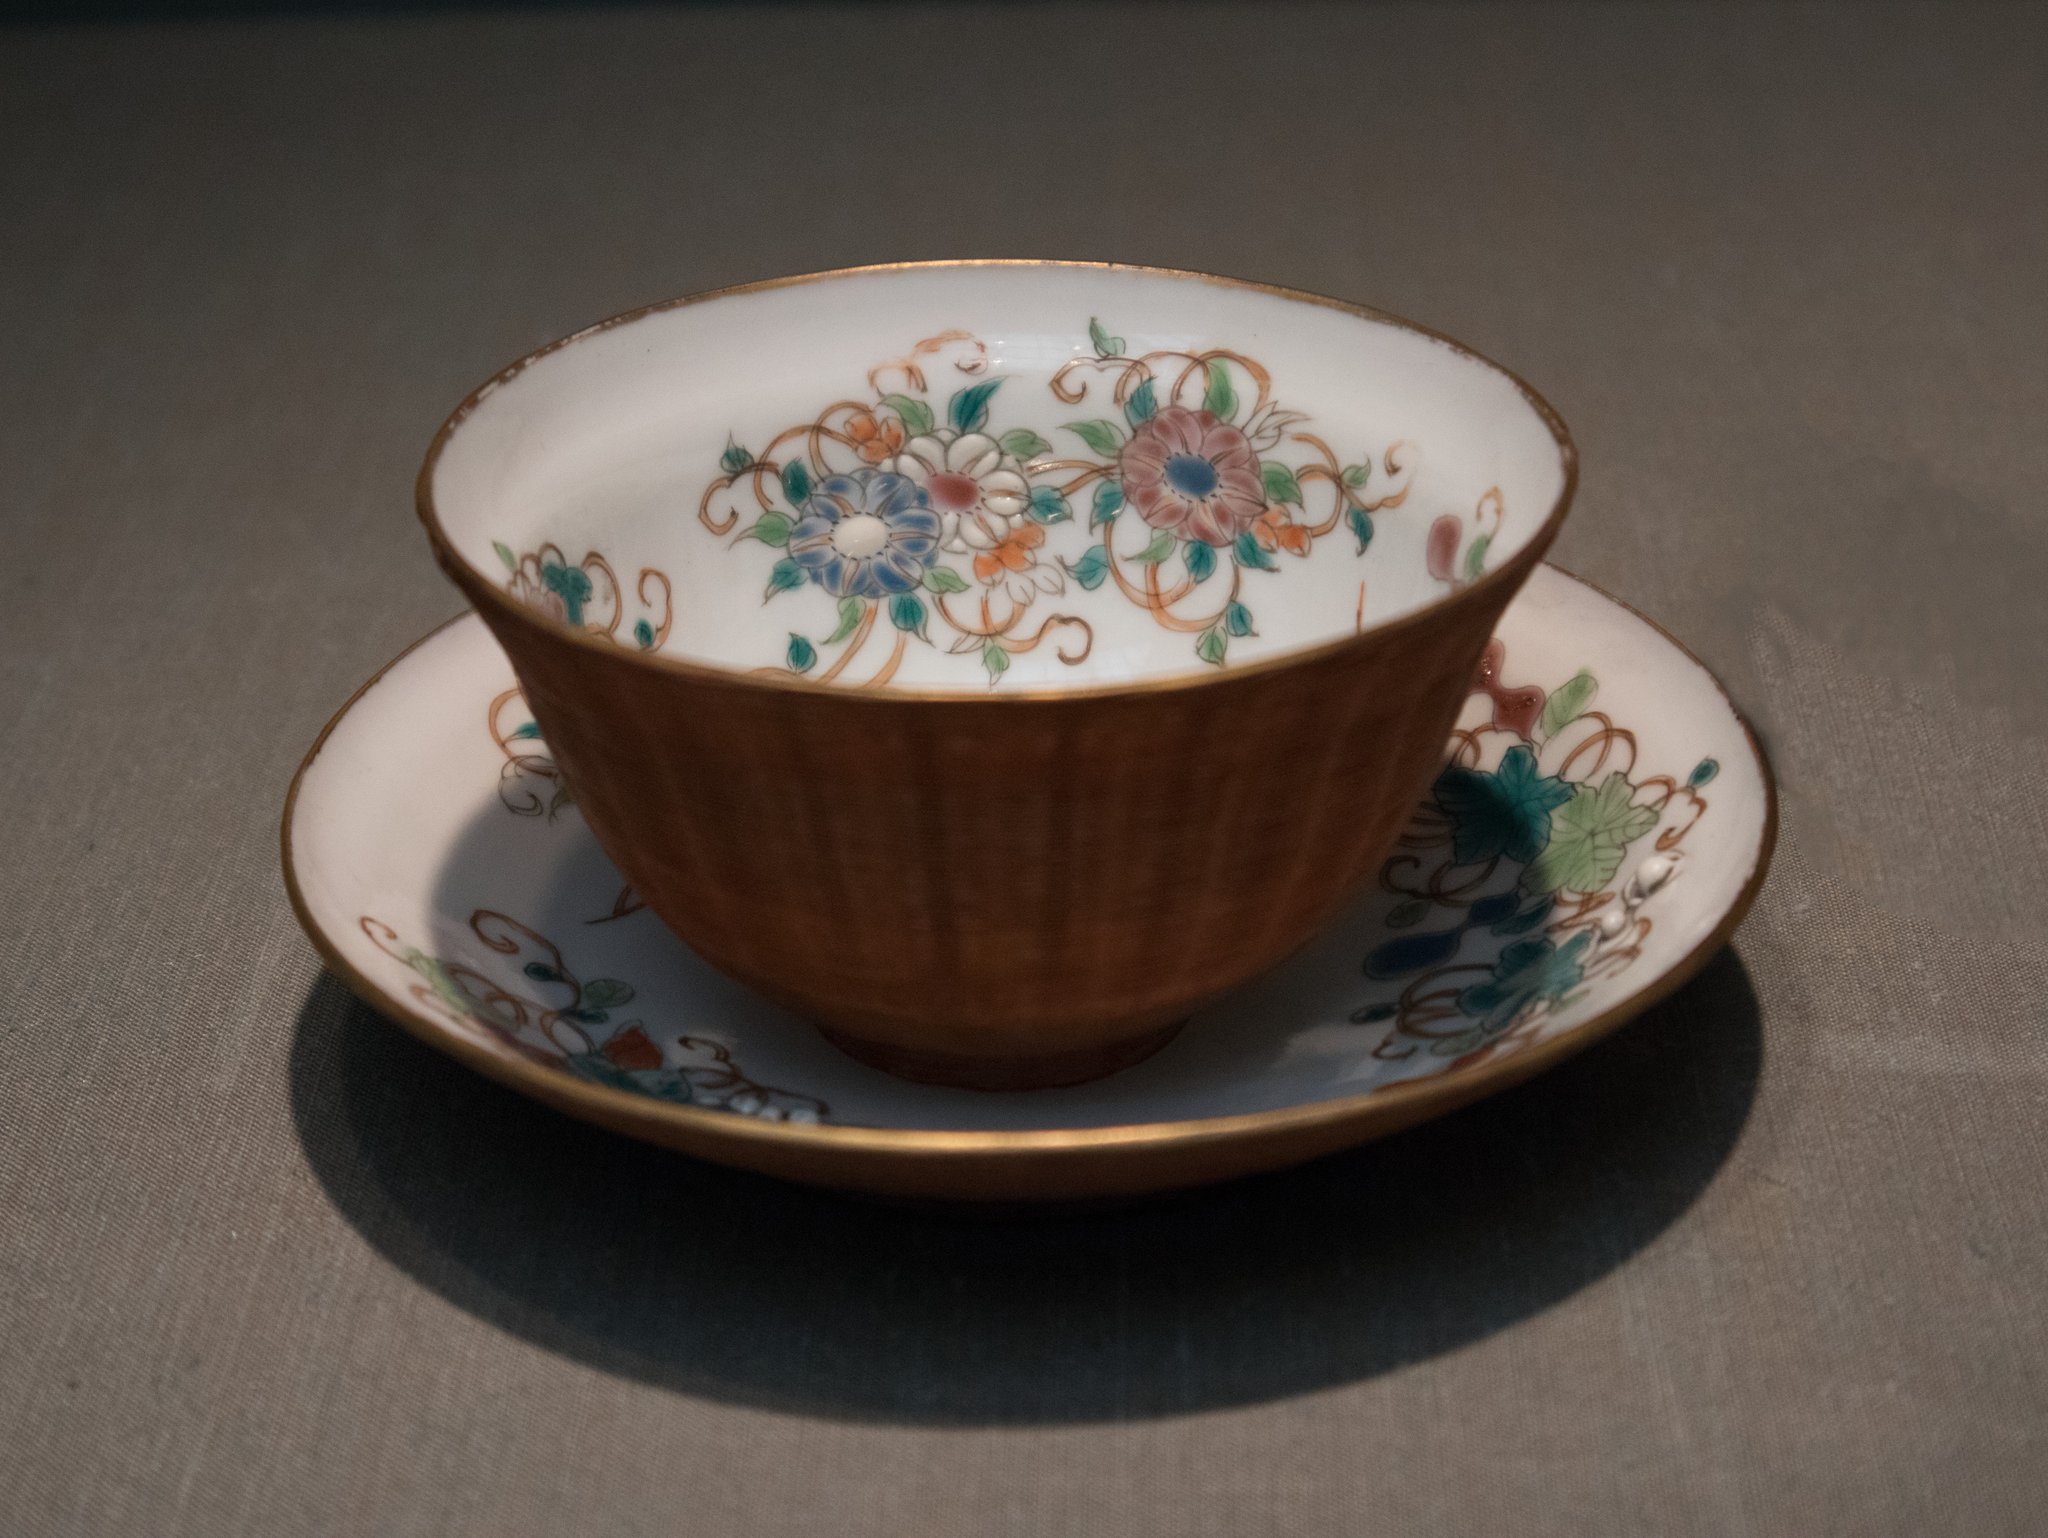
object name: cup with cover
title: Cup and Cover with Floral Design and Basketry Exterior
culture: japanese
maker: zōshuntei sanpo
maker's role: artist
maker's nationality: japanese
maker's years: 1841-1878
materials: enamel, glaze, porcelain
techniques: painting, polychrome